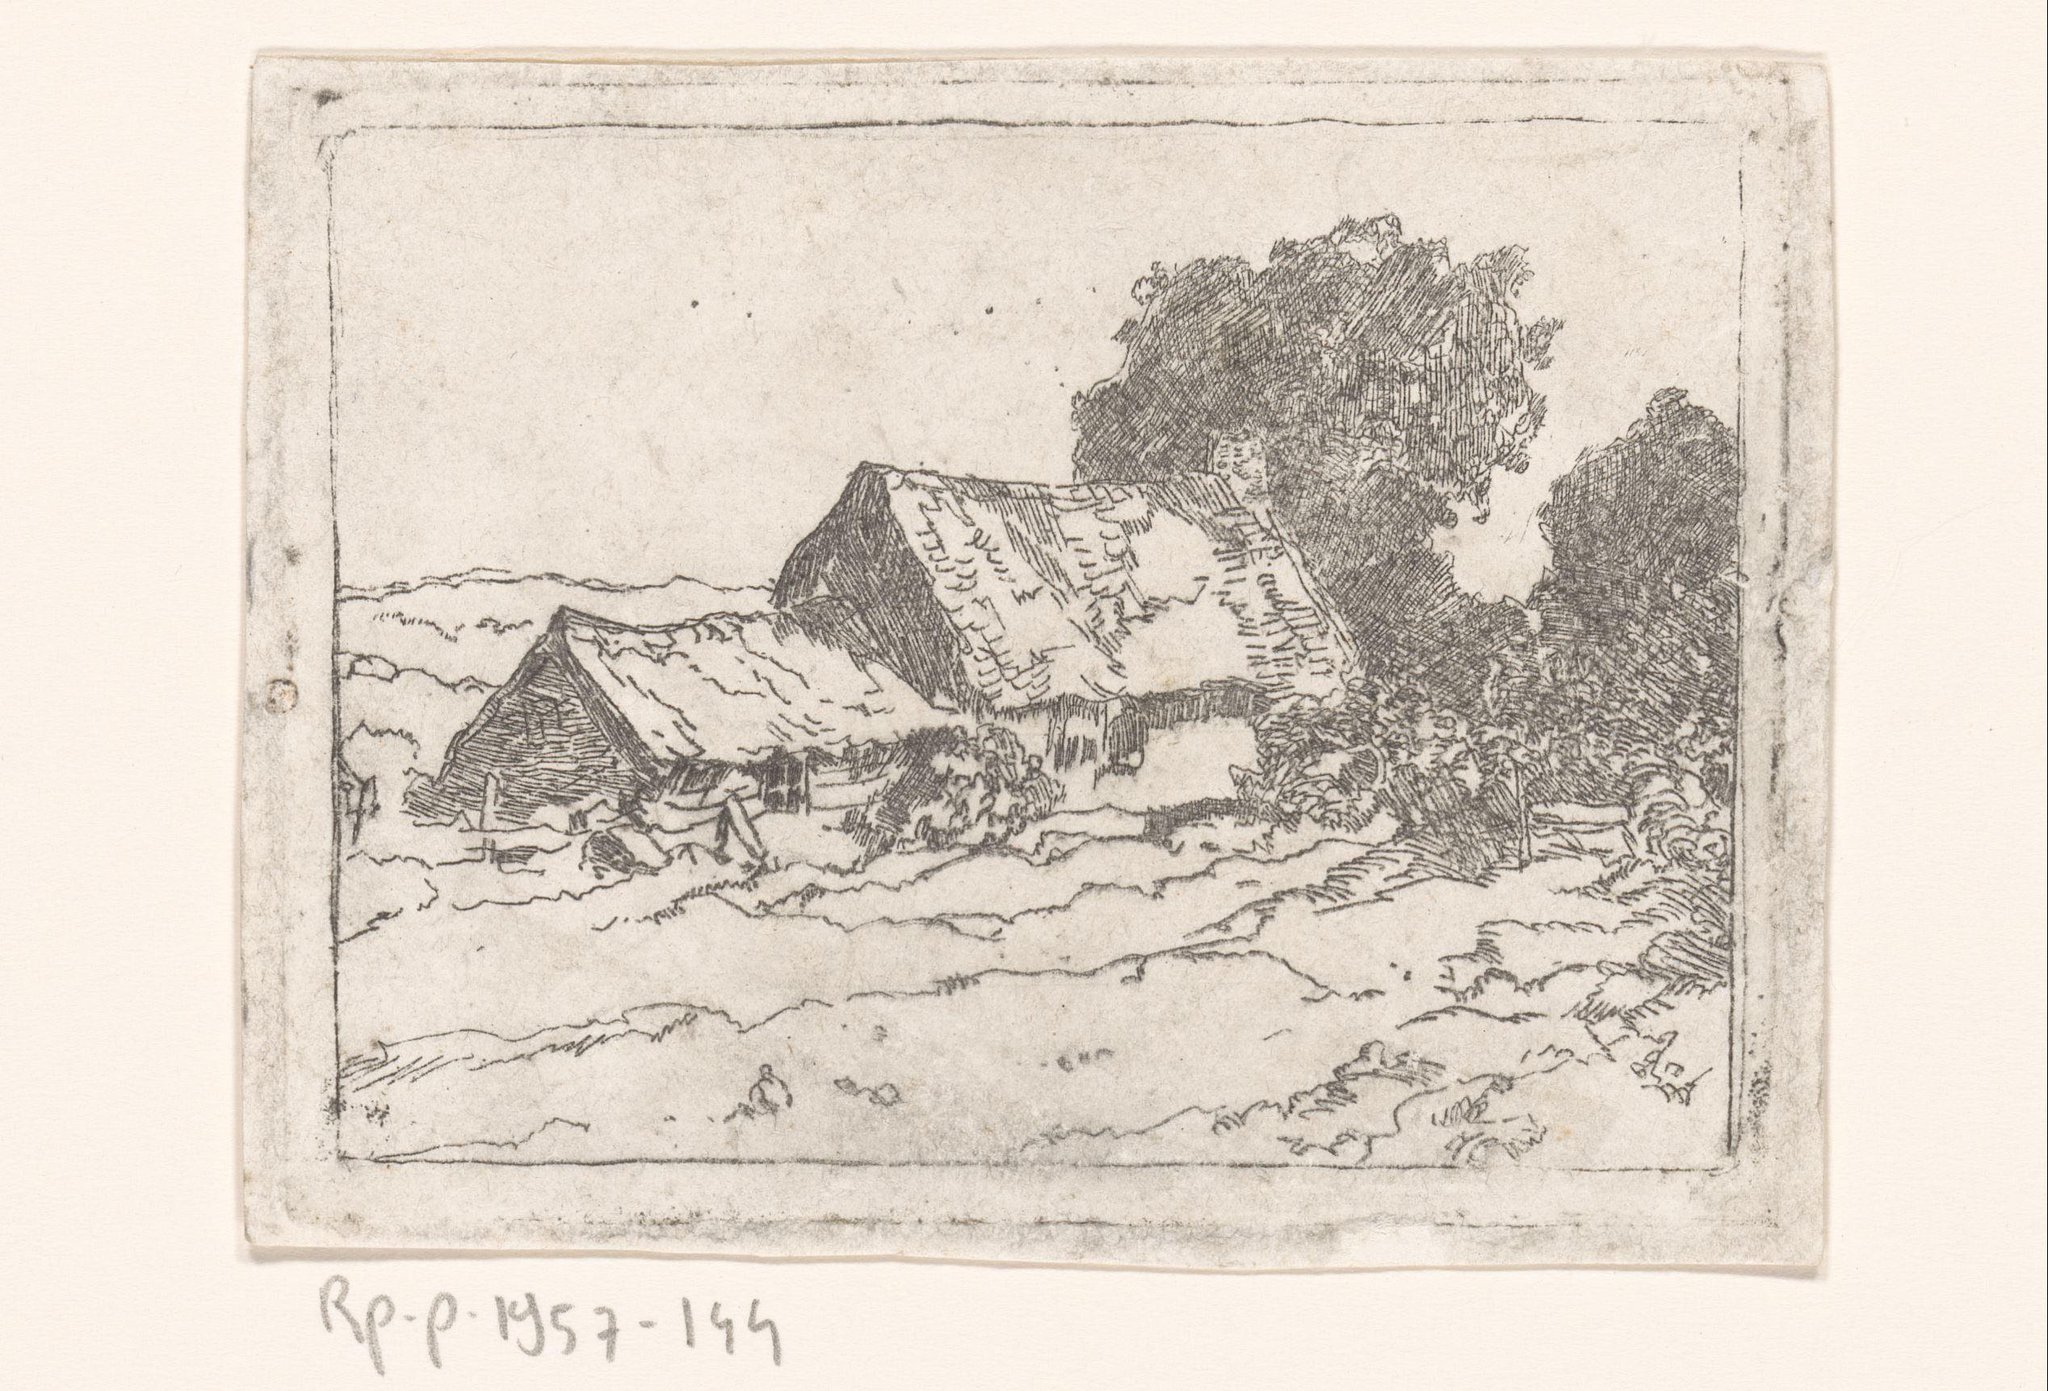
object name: print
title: Boerderij in heuvelachtig landschap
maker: chris van der windt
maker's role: print maker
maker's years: 1877-1952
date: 1887-1952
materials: paper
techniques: etching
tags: farm or solitary house in landscape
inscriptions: collector's mark: Lugt 2228